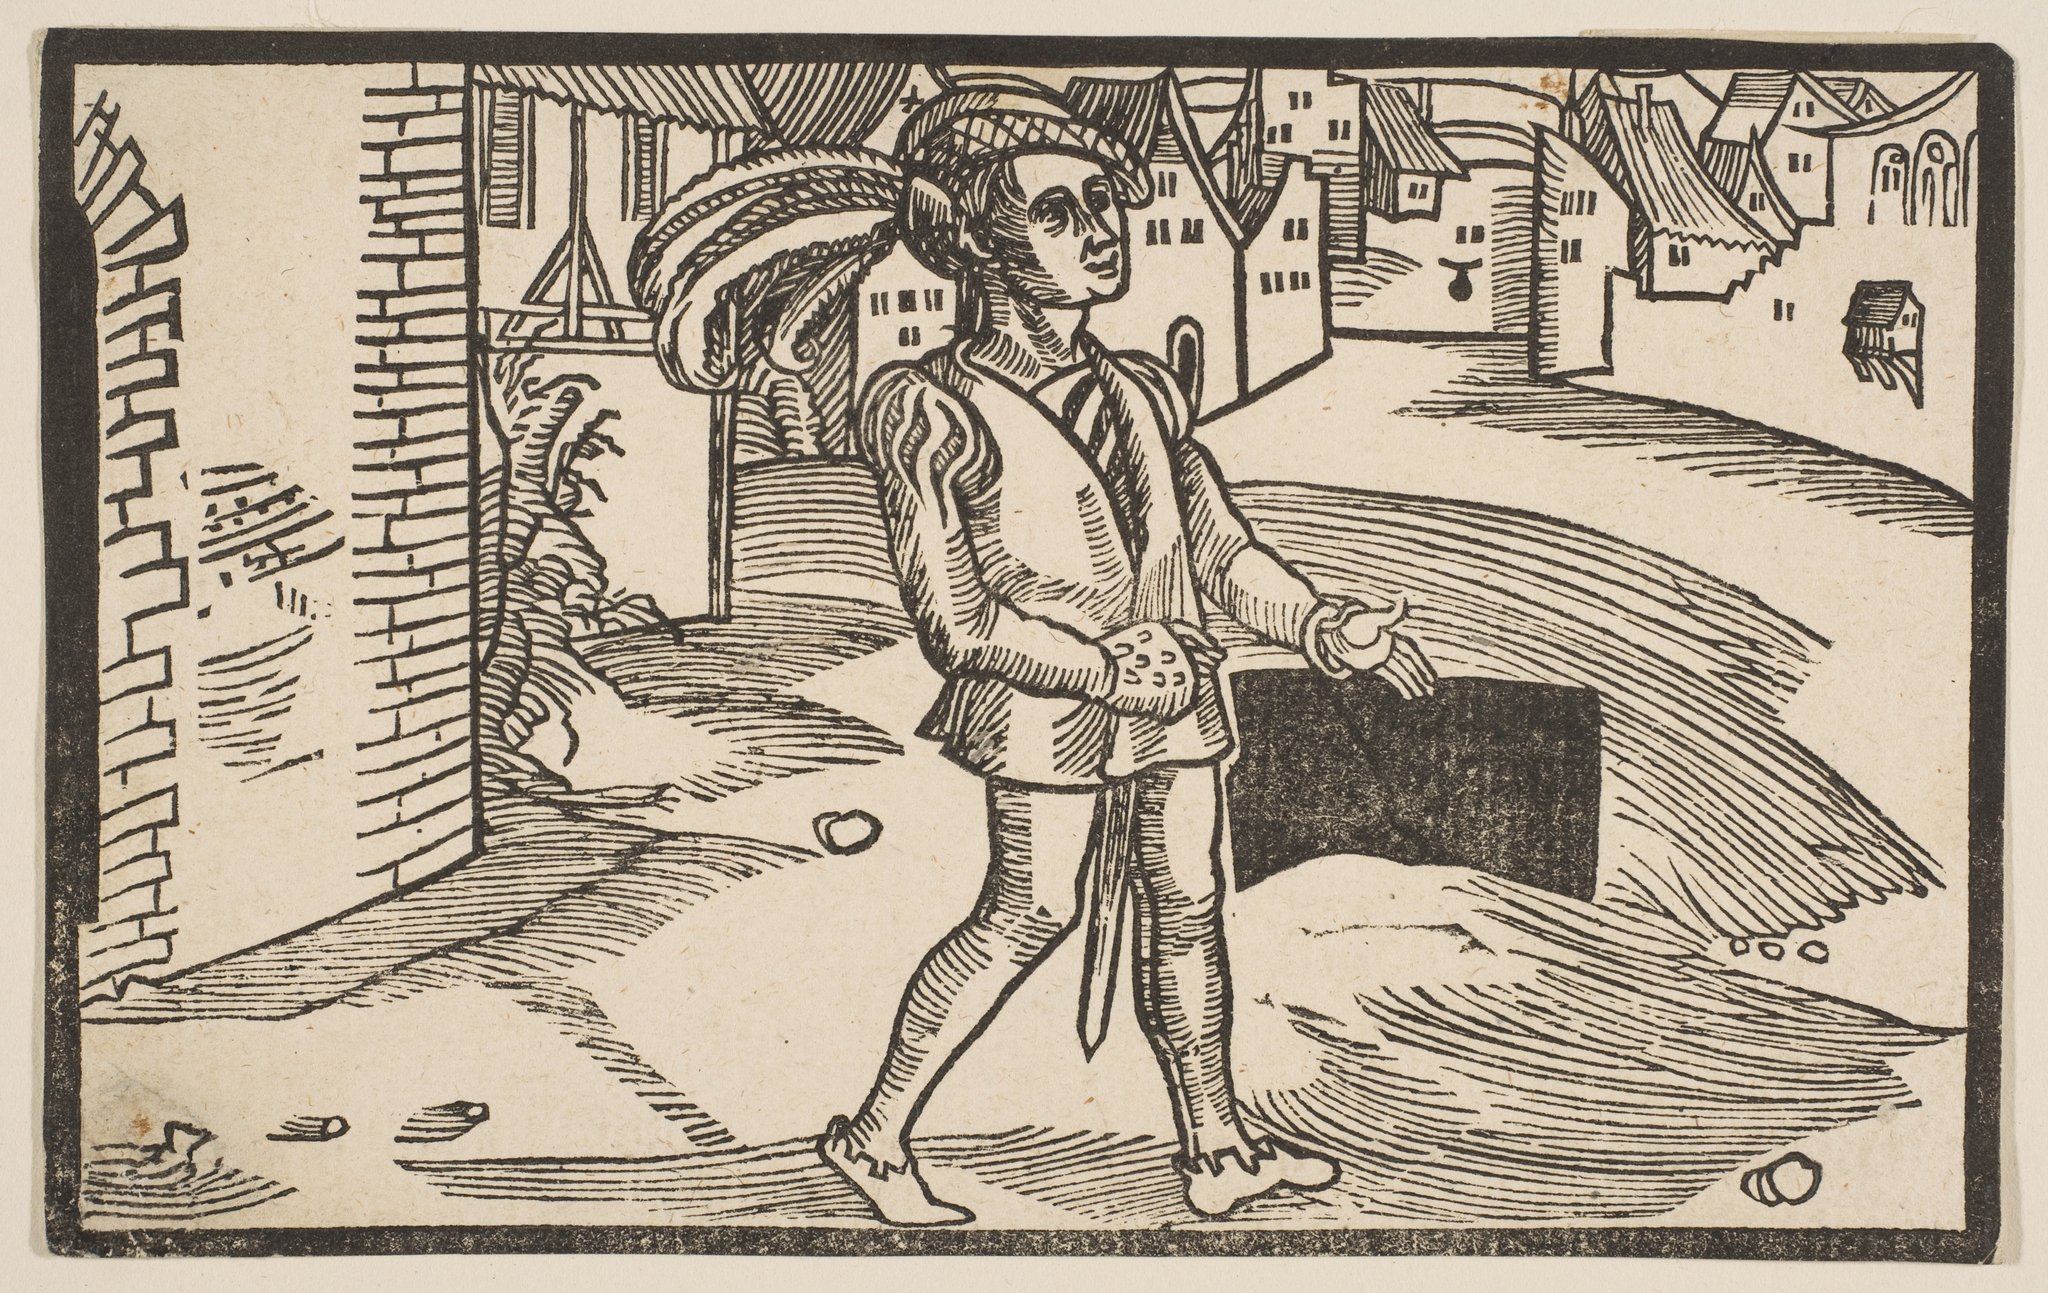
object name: print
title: Phormio, from "The Comedie of Terence", 19th century reprint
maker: albrecht dürer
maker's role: artist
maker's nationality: german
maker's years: 1471-1528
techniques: woodcut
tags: buildings,streets,men